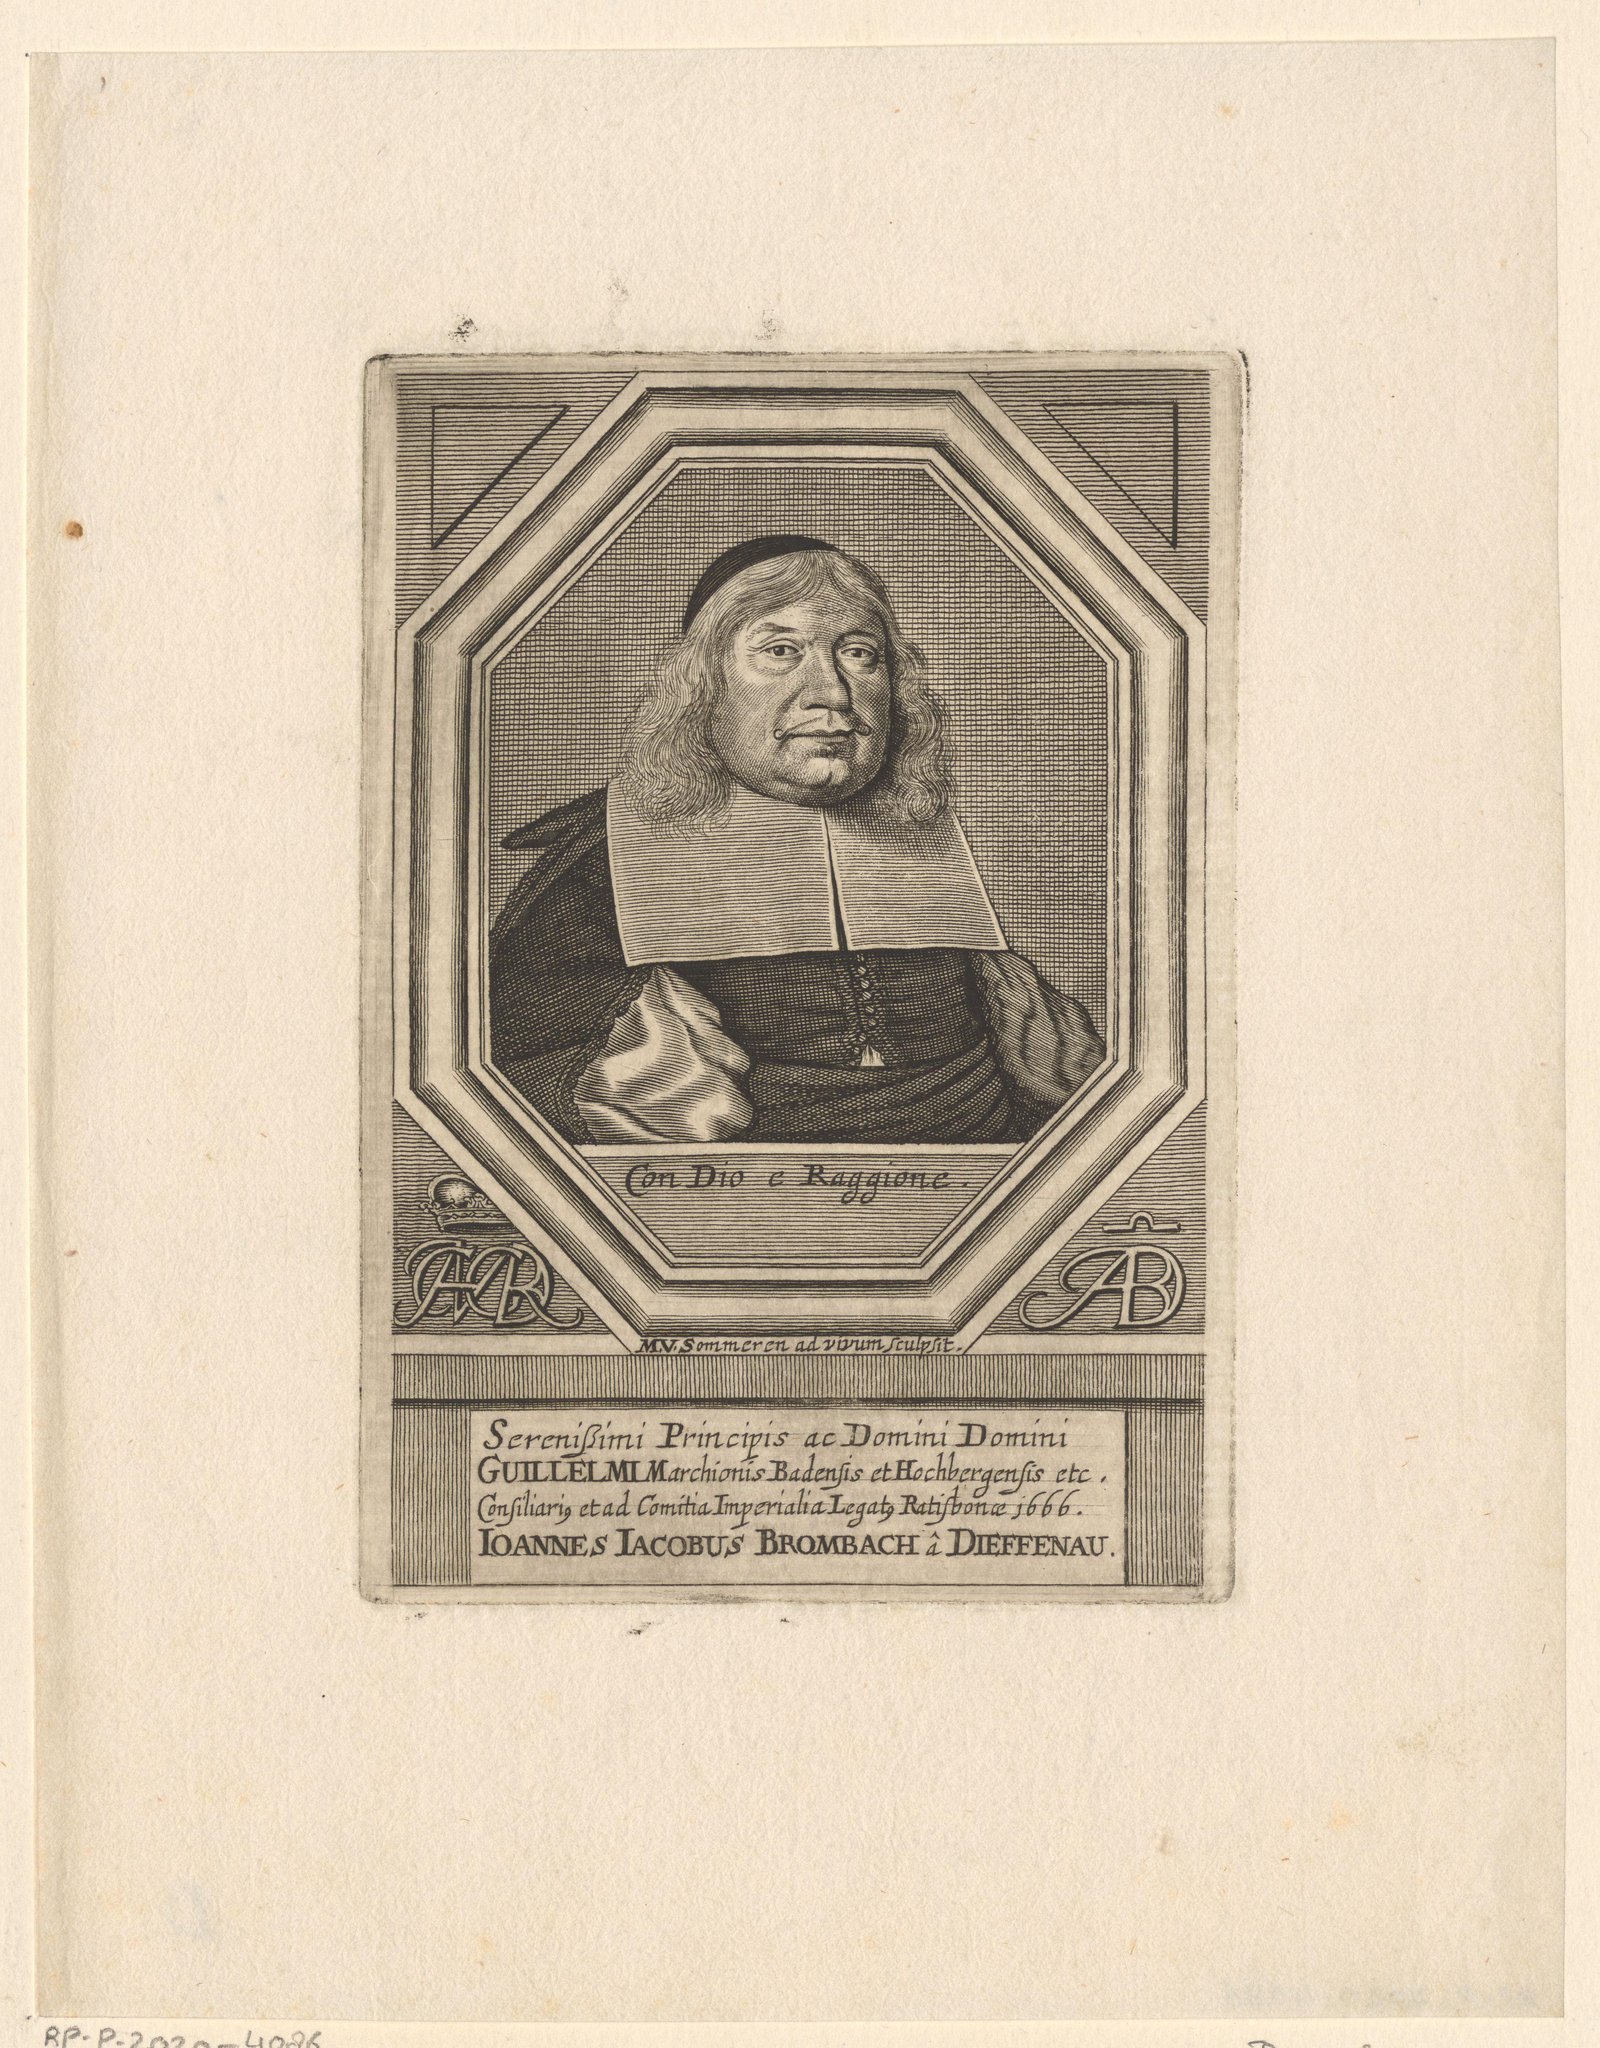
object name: book illustration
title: Portret van Johann Jacob Brombach von Dieffenau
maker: matthias van sommer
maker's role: draughtsman, print maker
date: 1667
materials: paper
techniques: engraving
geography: regensburg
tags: historical persons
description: Prent uit: [Somer, Matthias van]. Hasce omnium electorum principum ac statuum Sacri Romani Imperii ad comitia praesentia legatis ac deputatis icones (…). Regensburg: [Matthias van Somer], 1667.